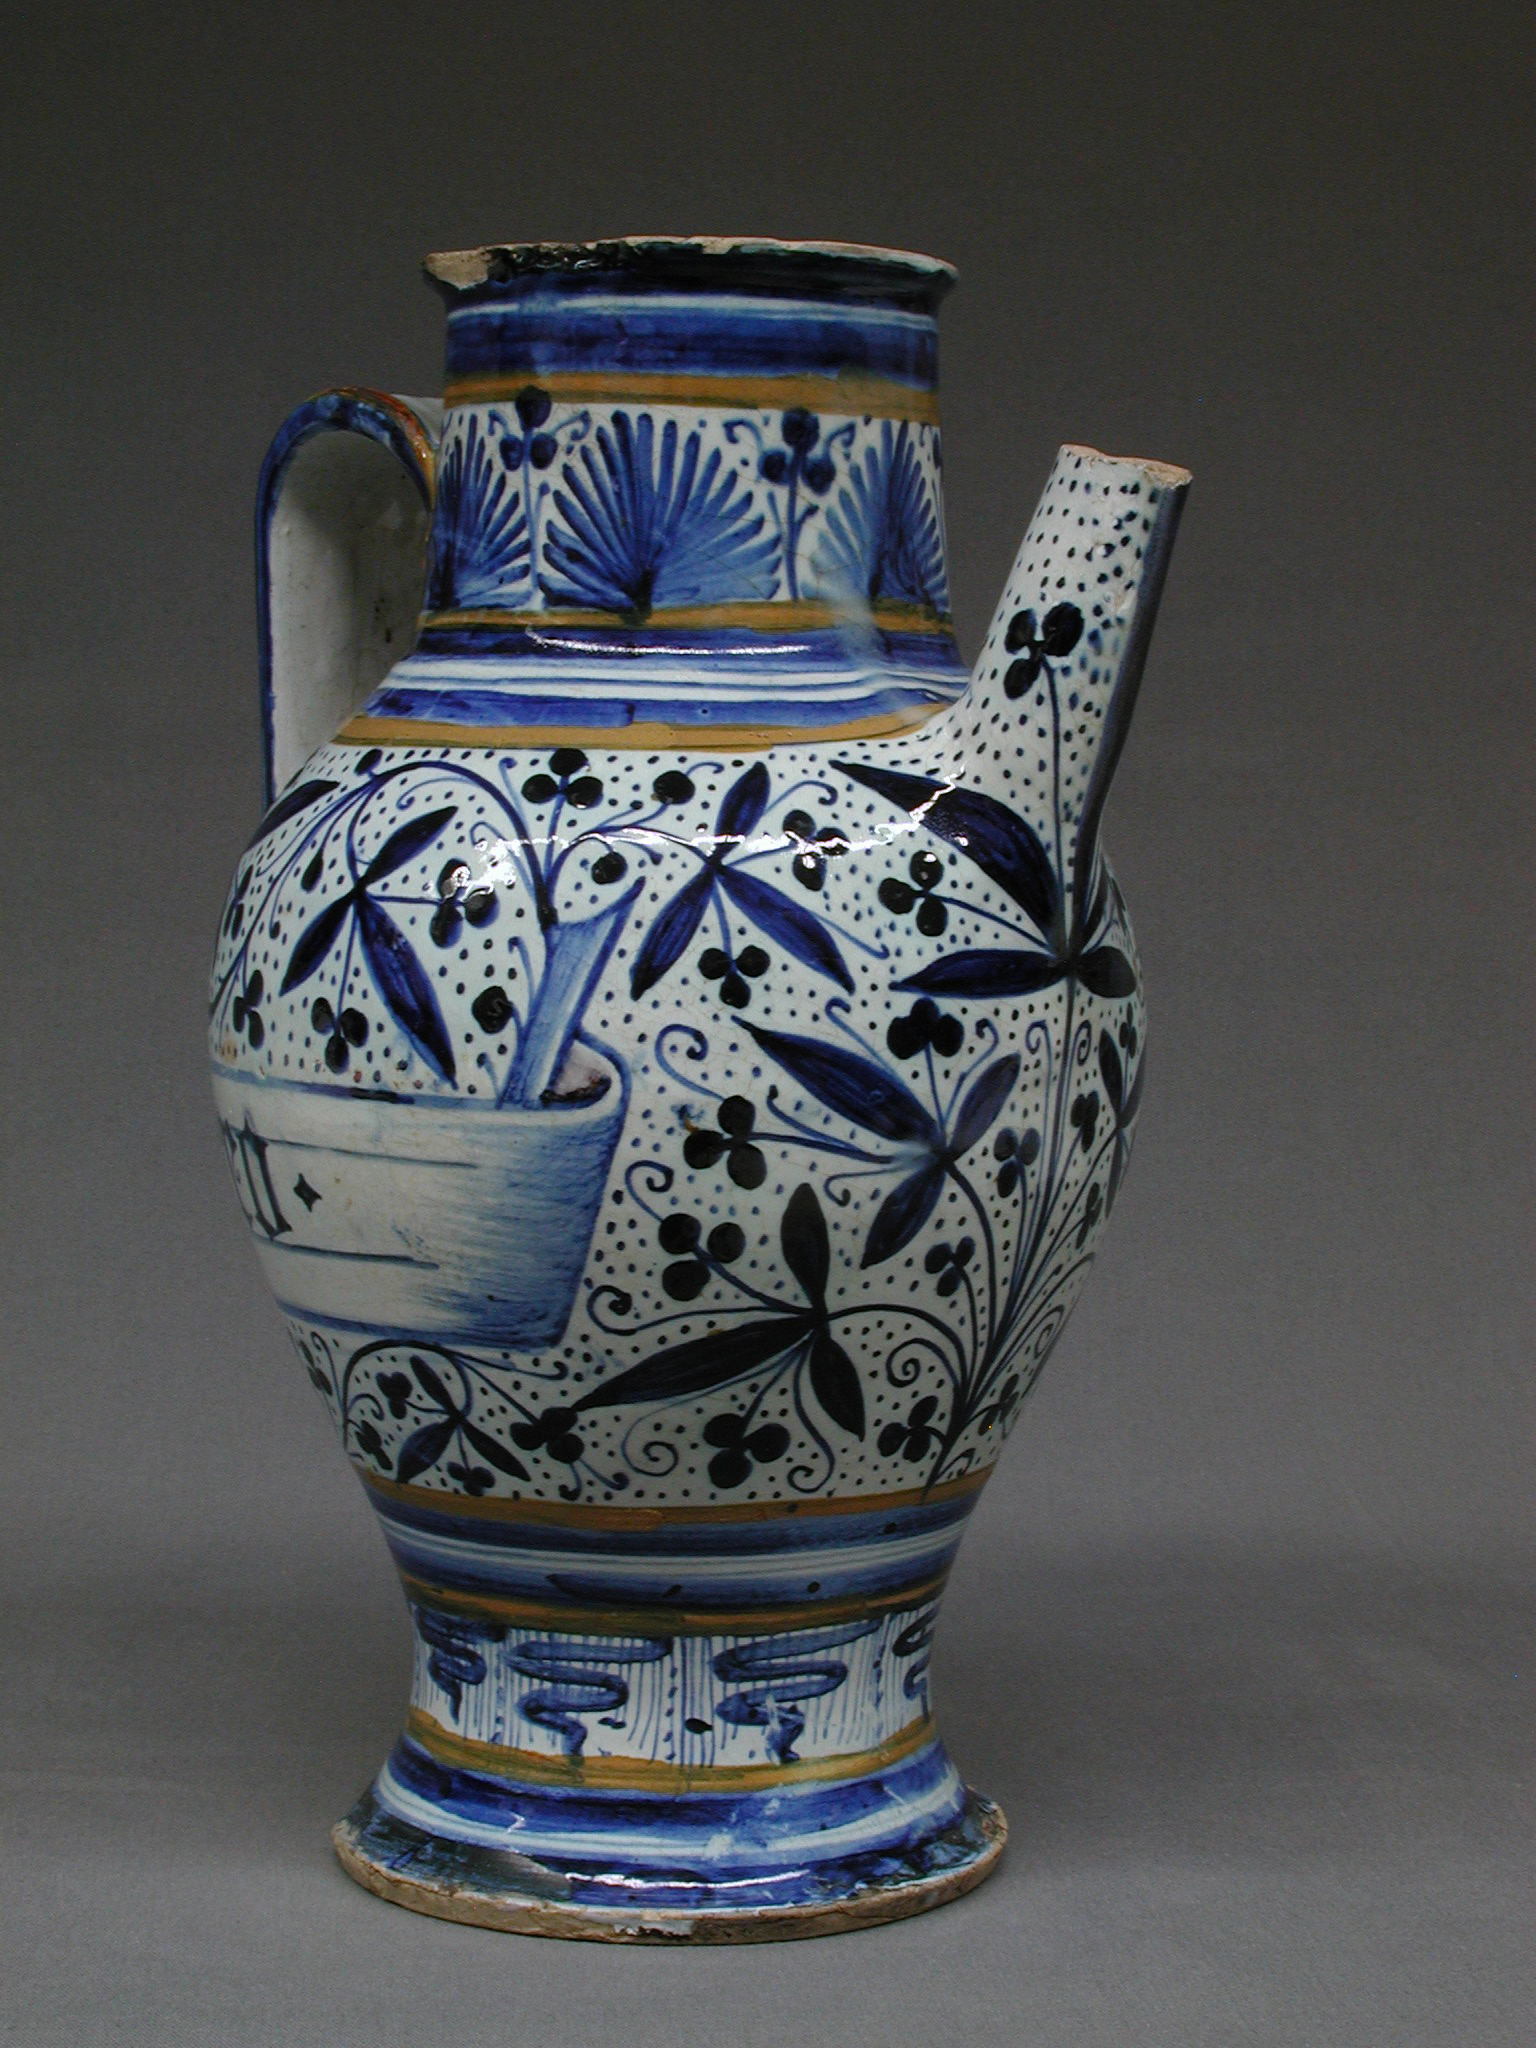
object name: pharmacy jar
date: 1470-1490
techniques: maiolica, glazing